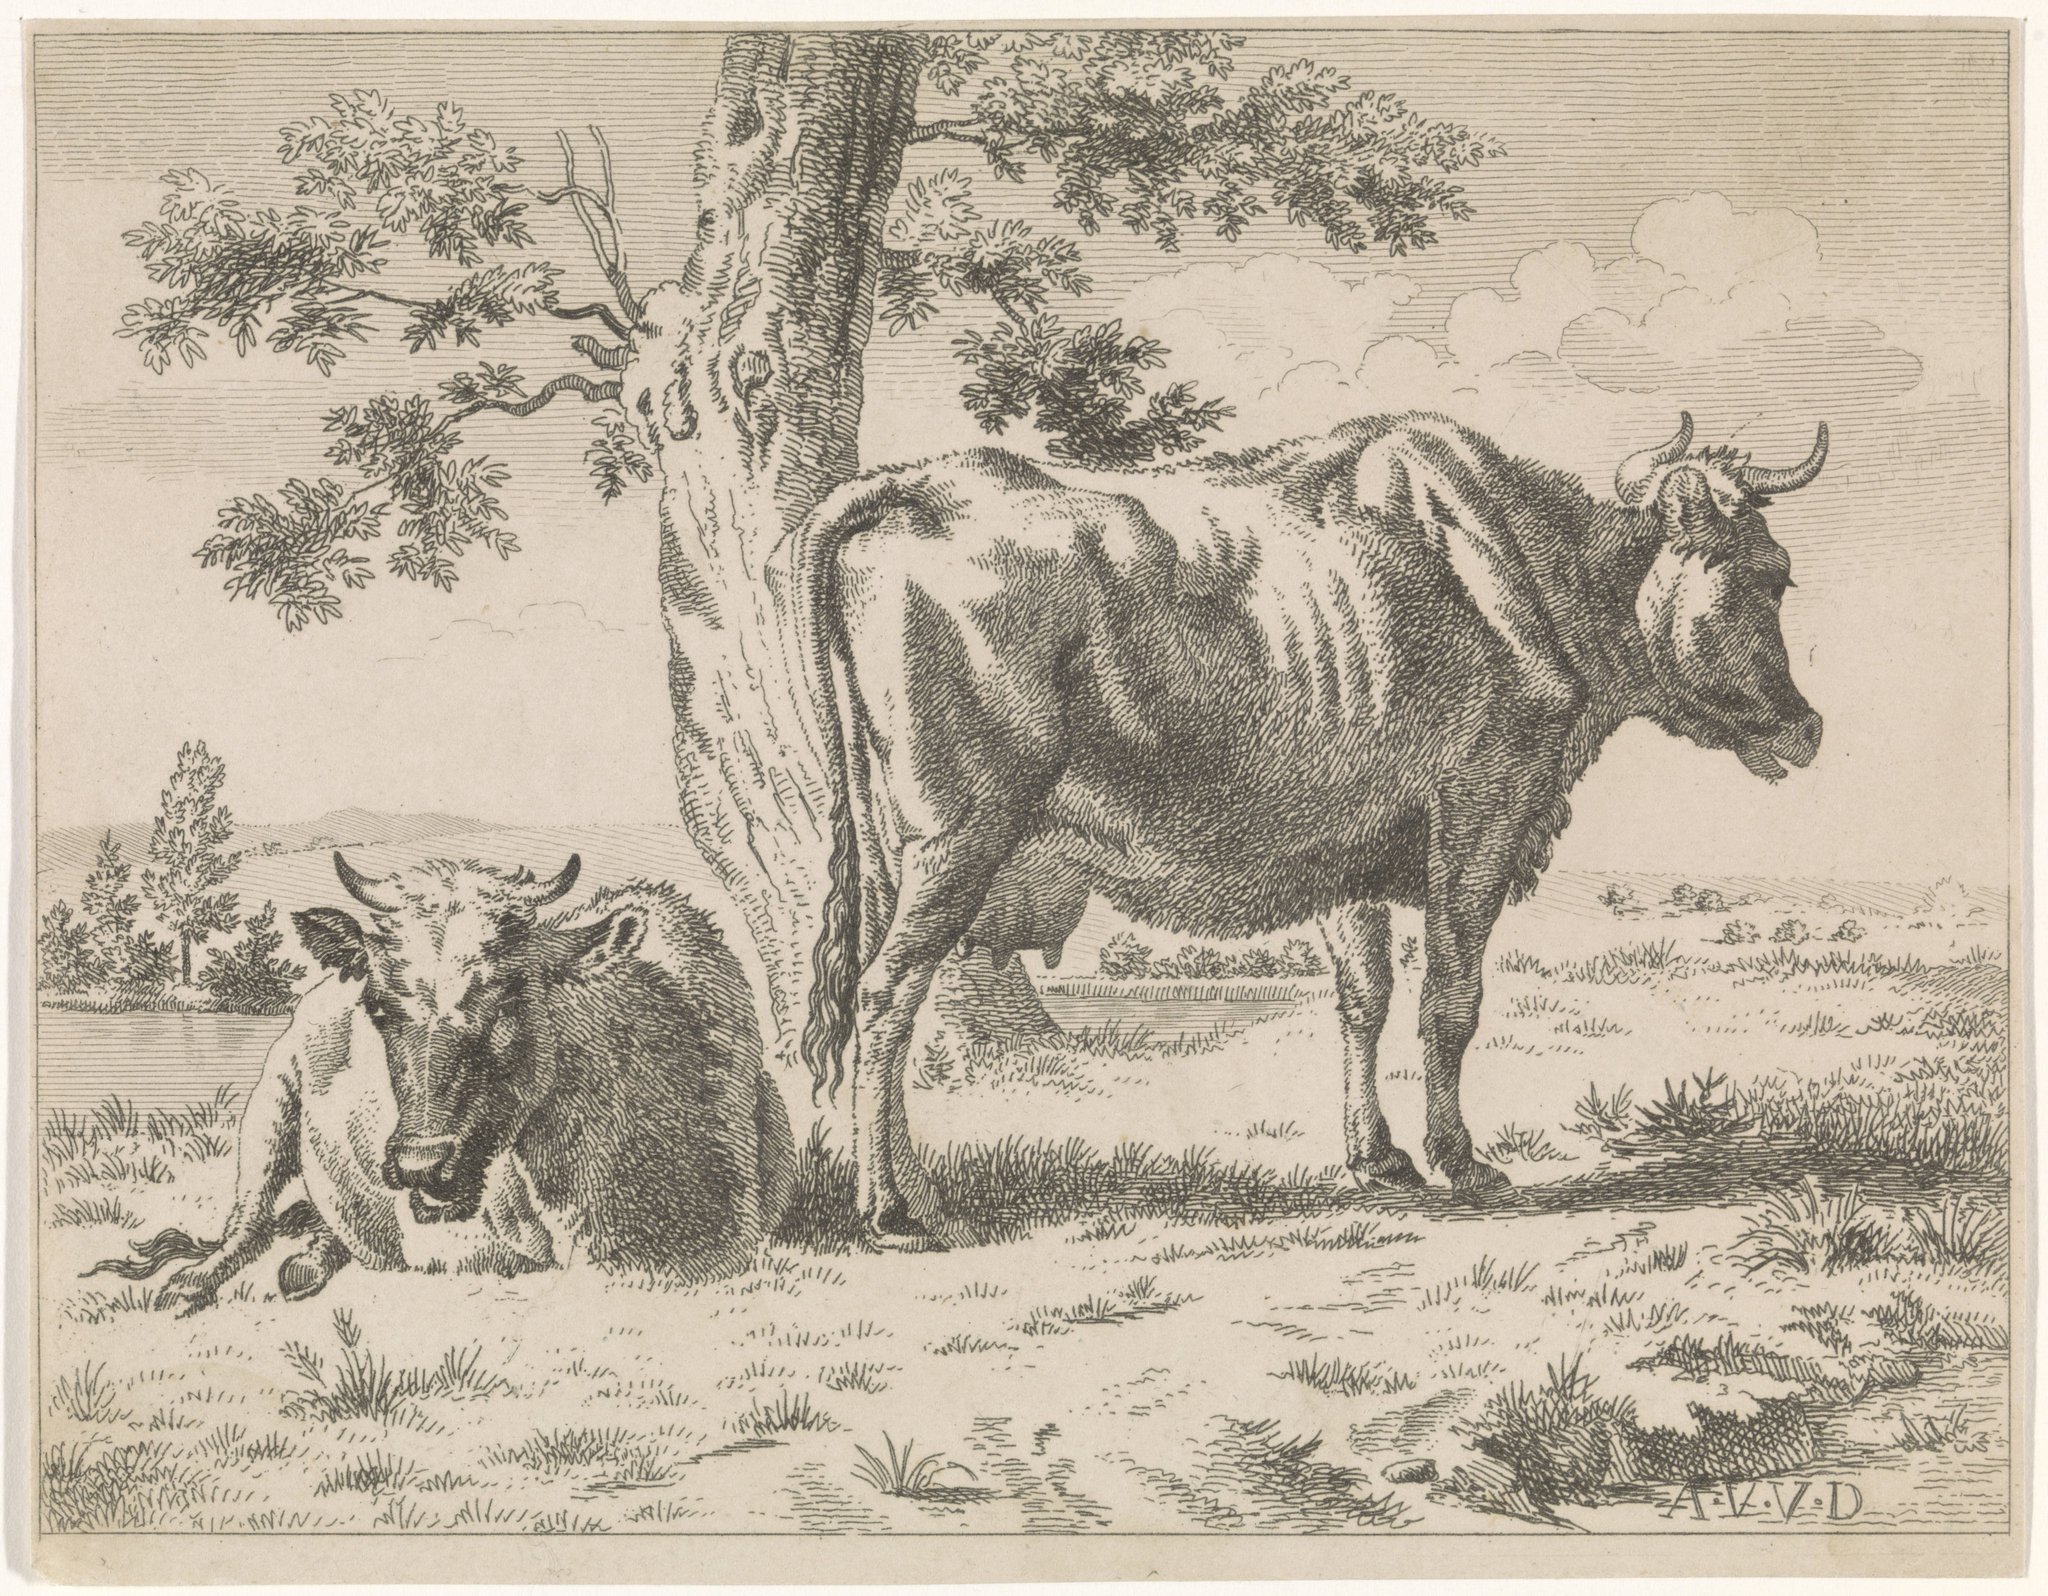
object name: print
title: Twee koeien bij een boom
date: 1670-1720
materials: paper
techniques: etching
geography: northern netherlands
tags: cow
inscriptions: collector's mark: Lugt 2228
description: Kopie van de prent uit de serie van Adriaen van de Velde.